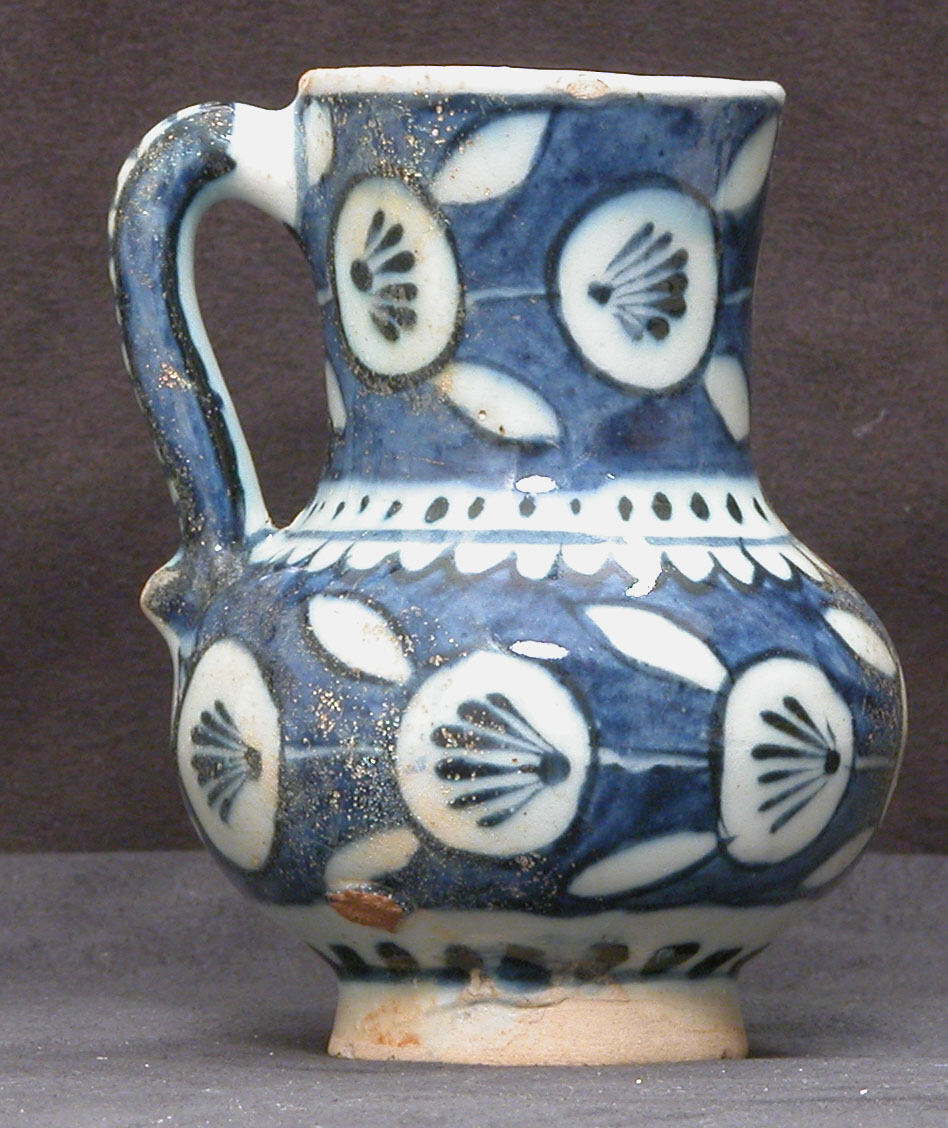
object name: ewer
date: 1601-1700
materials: glaze, stonepaste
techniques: painting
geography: syria